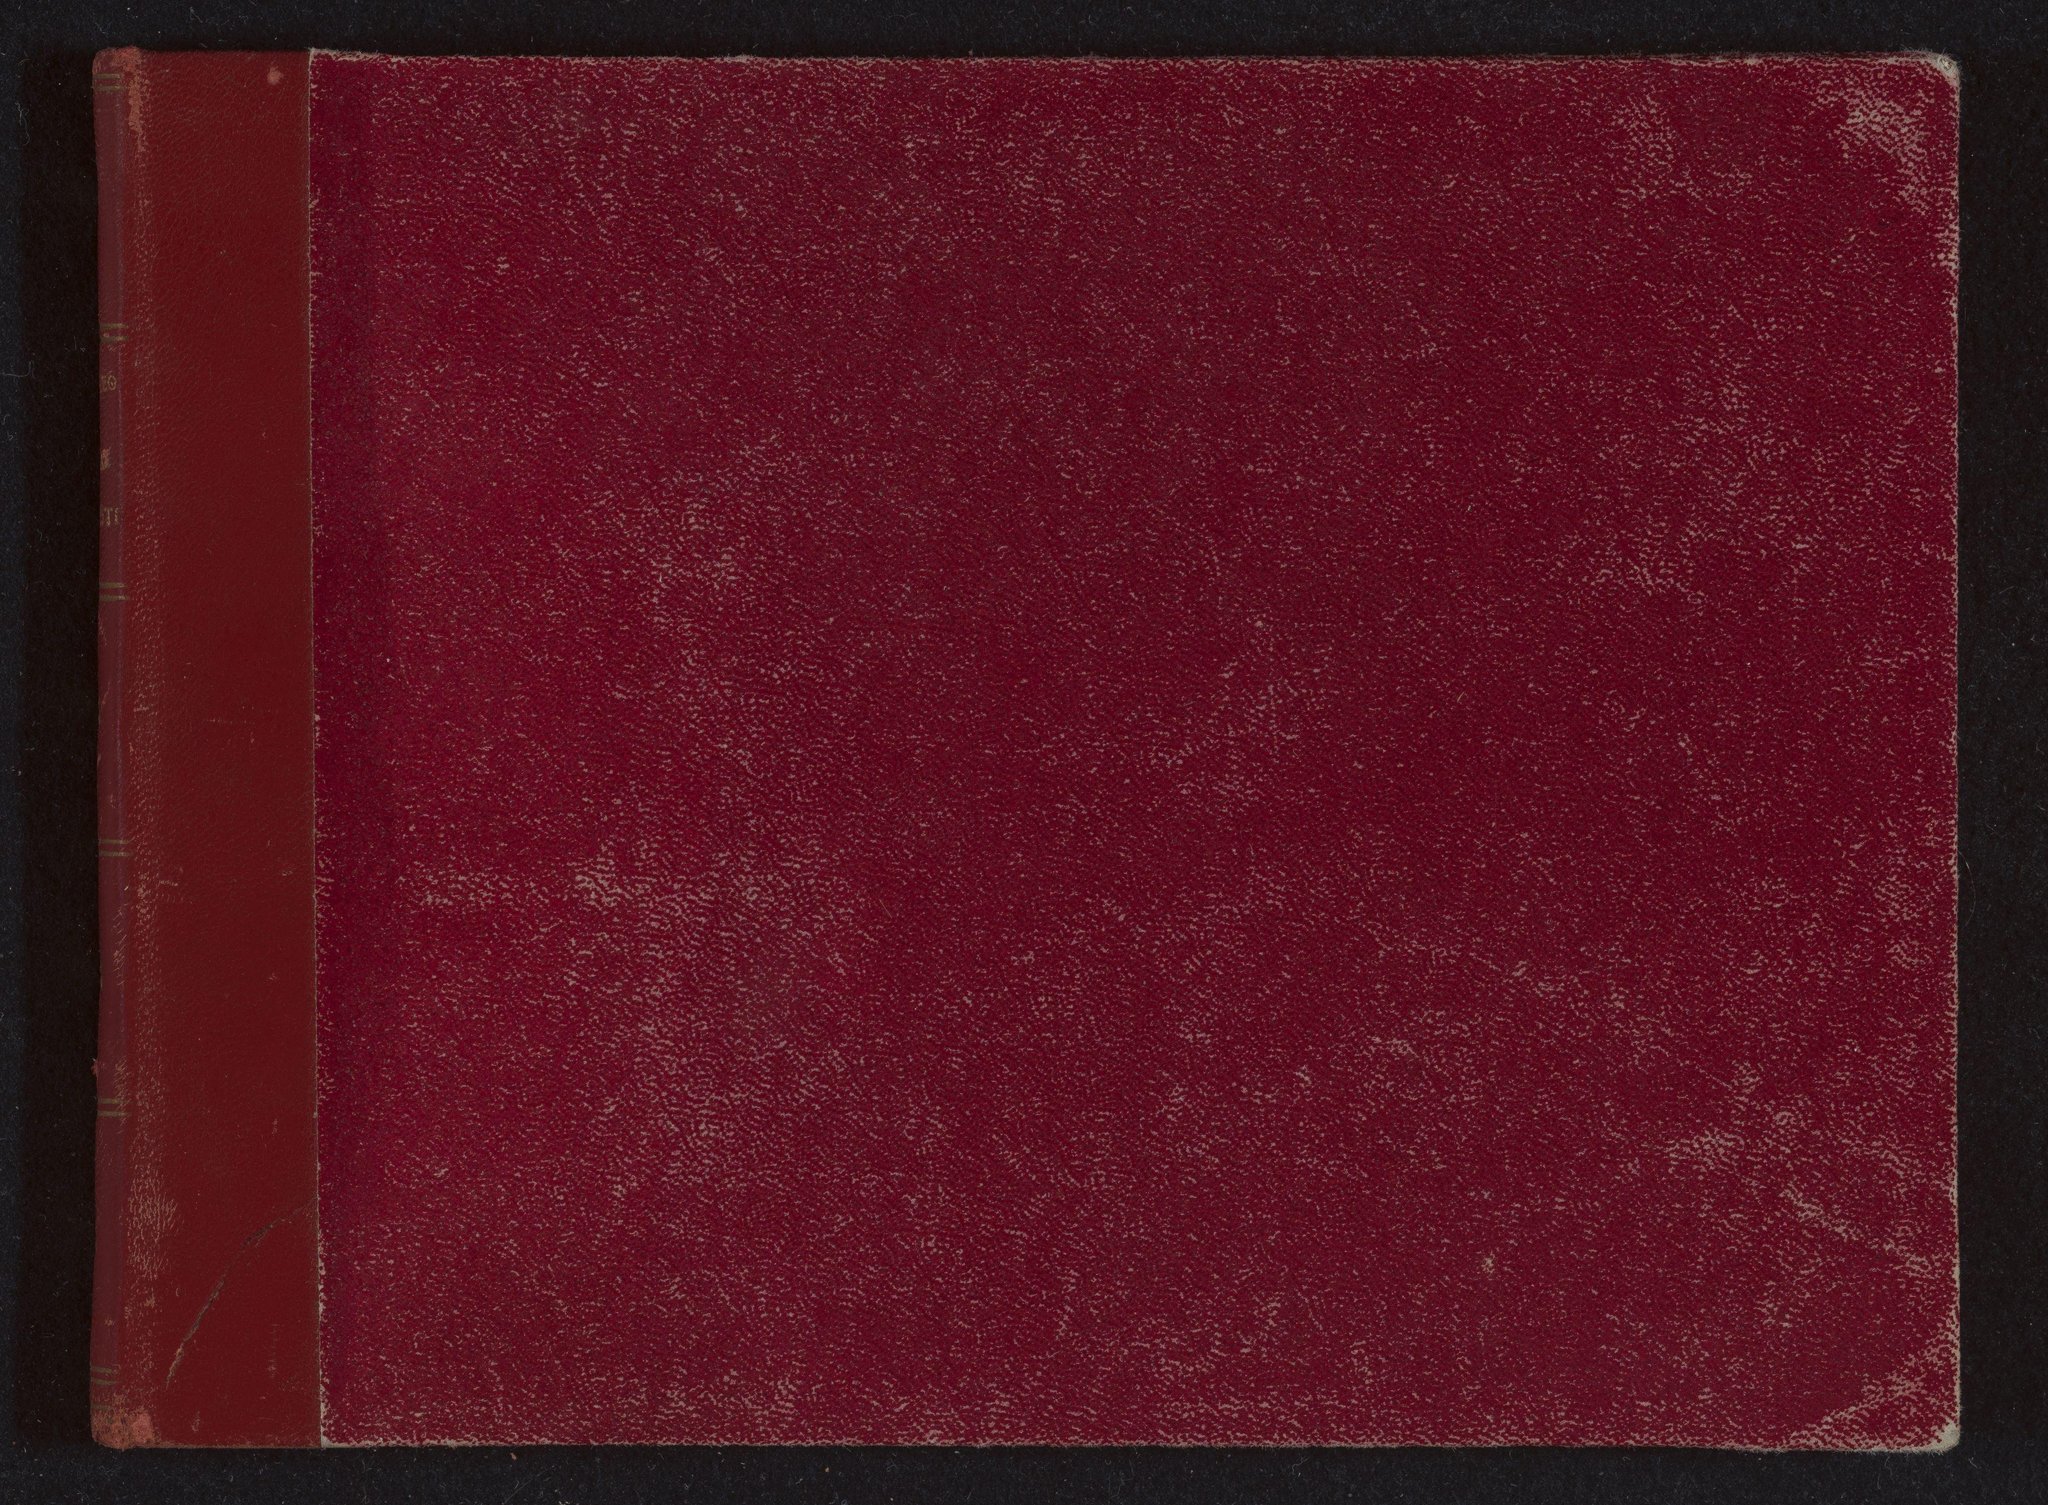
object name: titelprent, frontispice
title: Christi Iesu vitae admirabiliumque actionum speculum a Philippo Gallaeo apparatum Bened. Ariae Montani singuloribus distichis instructum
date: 1573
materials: paper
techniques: engraving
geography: antwerp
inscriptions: collector's mark: Lugt 2760, watermark: ‘gotische letter P’, collector's mark: Lugt 2228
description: Album met een titelprent en een serie van 50 prenten betreffende het leven en de passie van Christus. Deze editie met alleen de (verkleinde) platen, zonder teksten, maar wel met de cijfers.